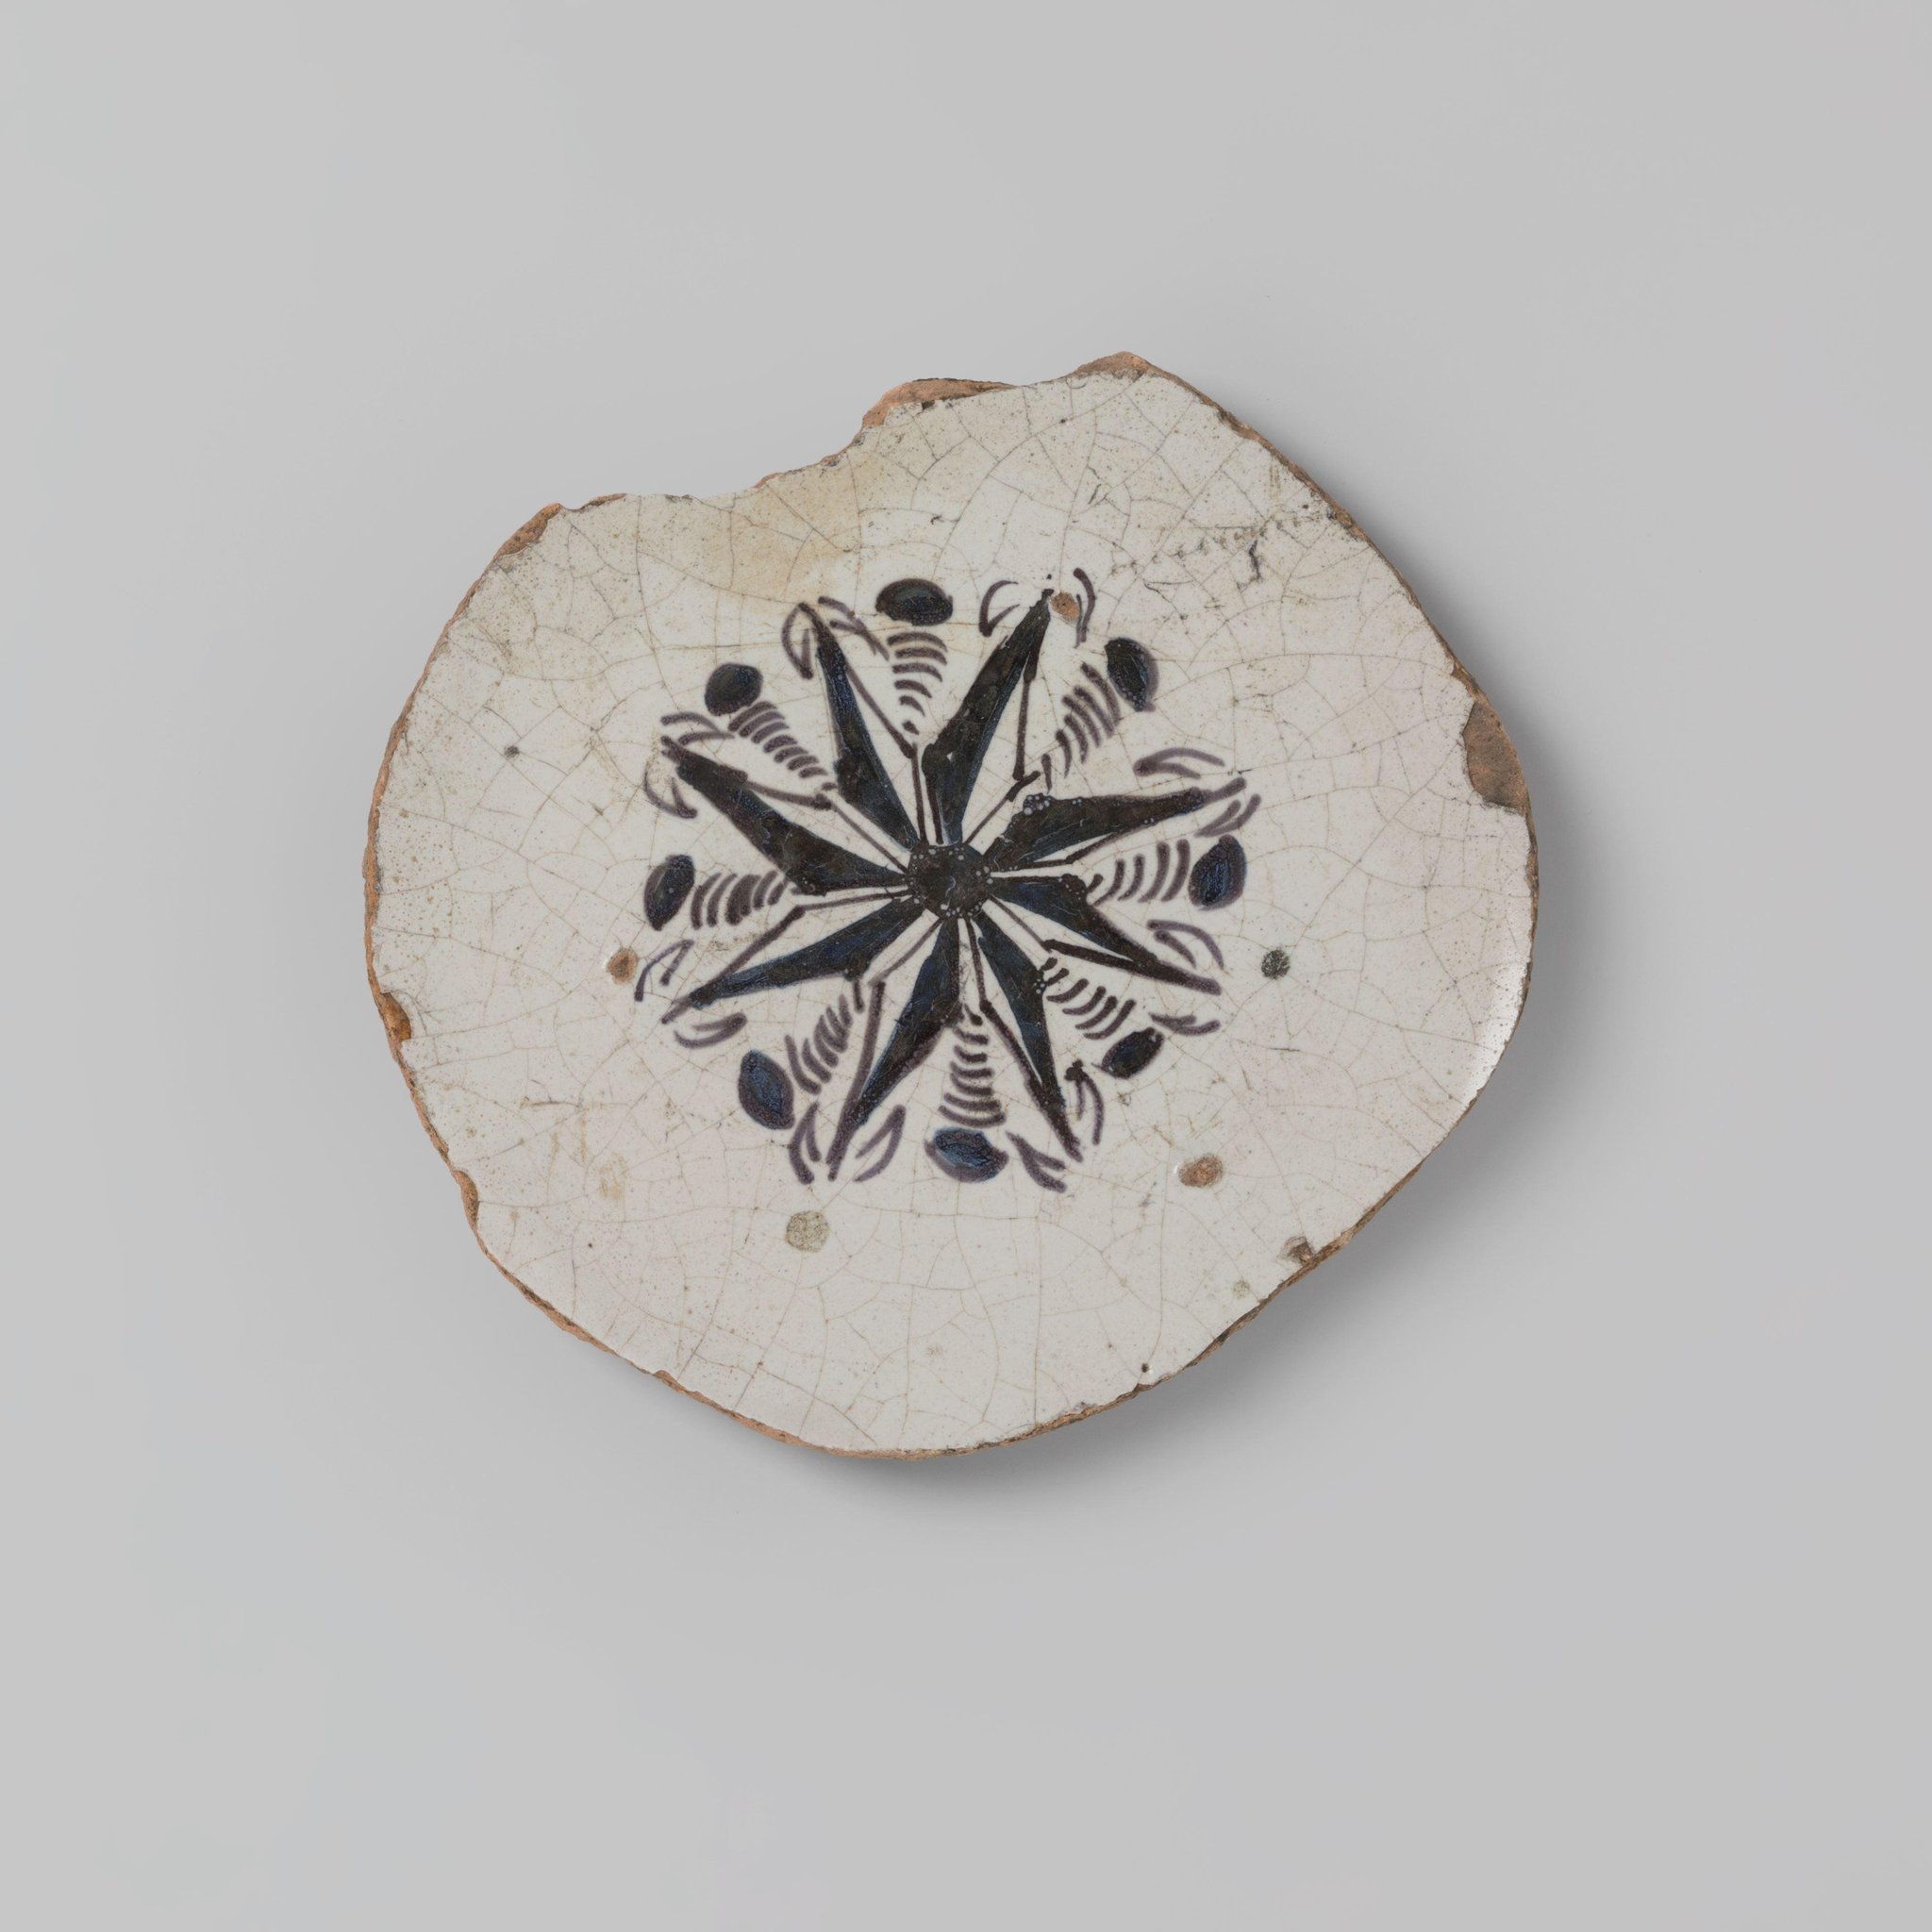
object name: sherd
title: Schotelscherf van aardewerk voorzien van een tekening van een ster in mangaan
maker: Anonymous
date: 1500-1799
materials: earthenware, glaze